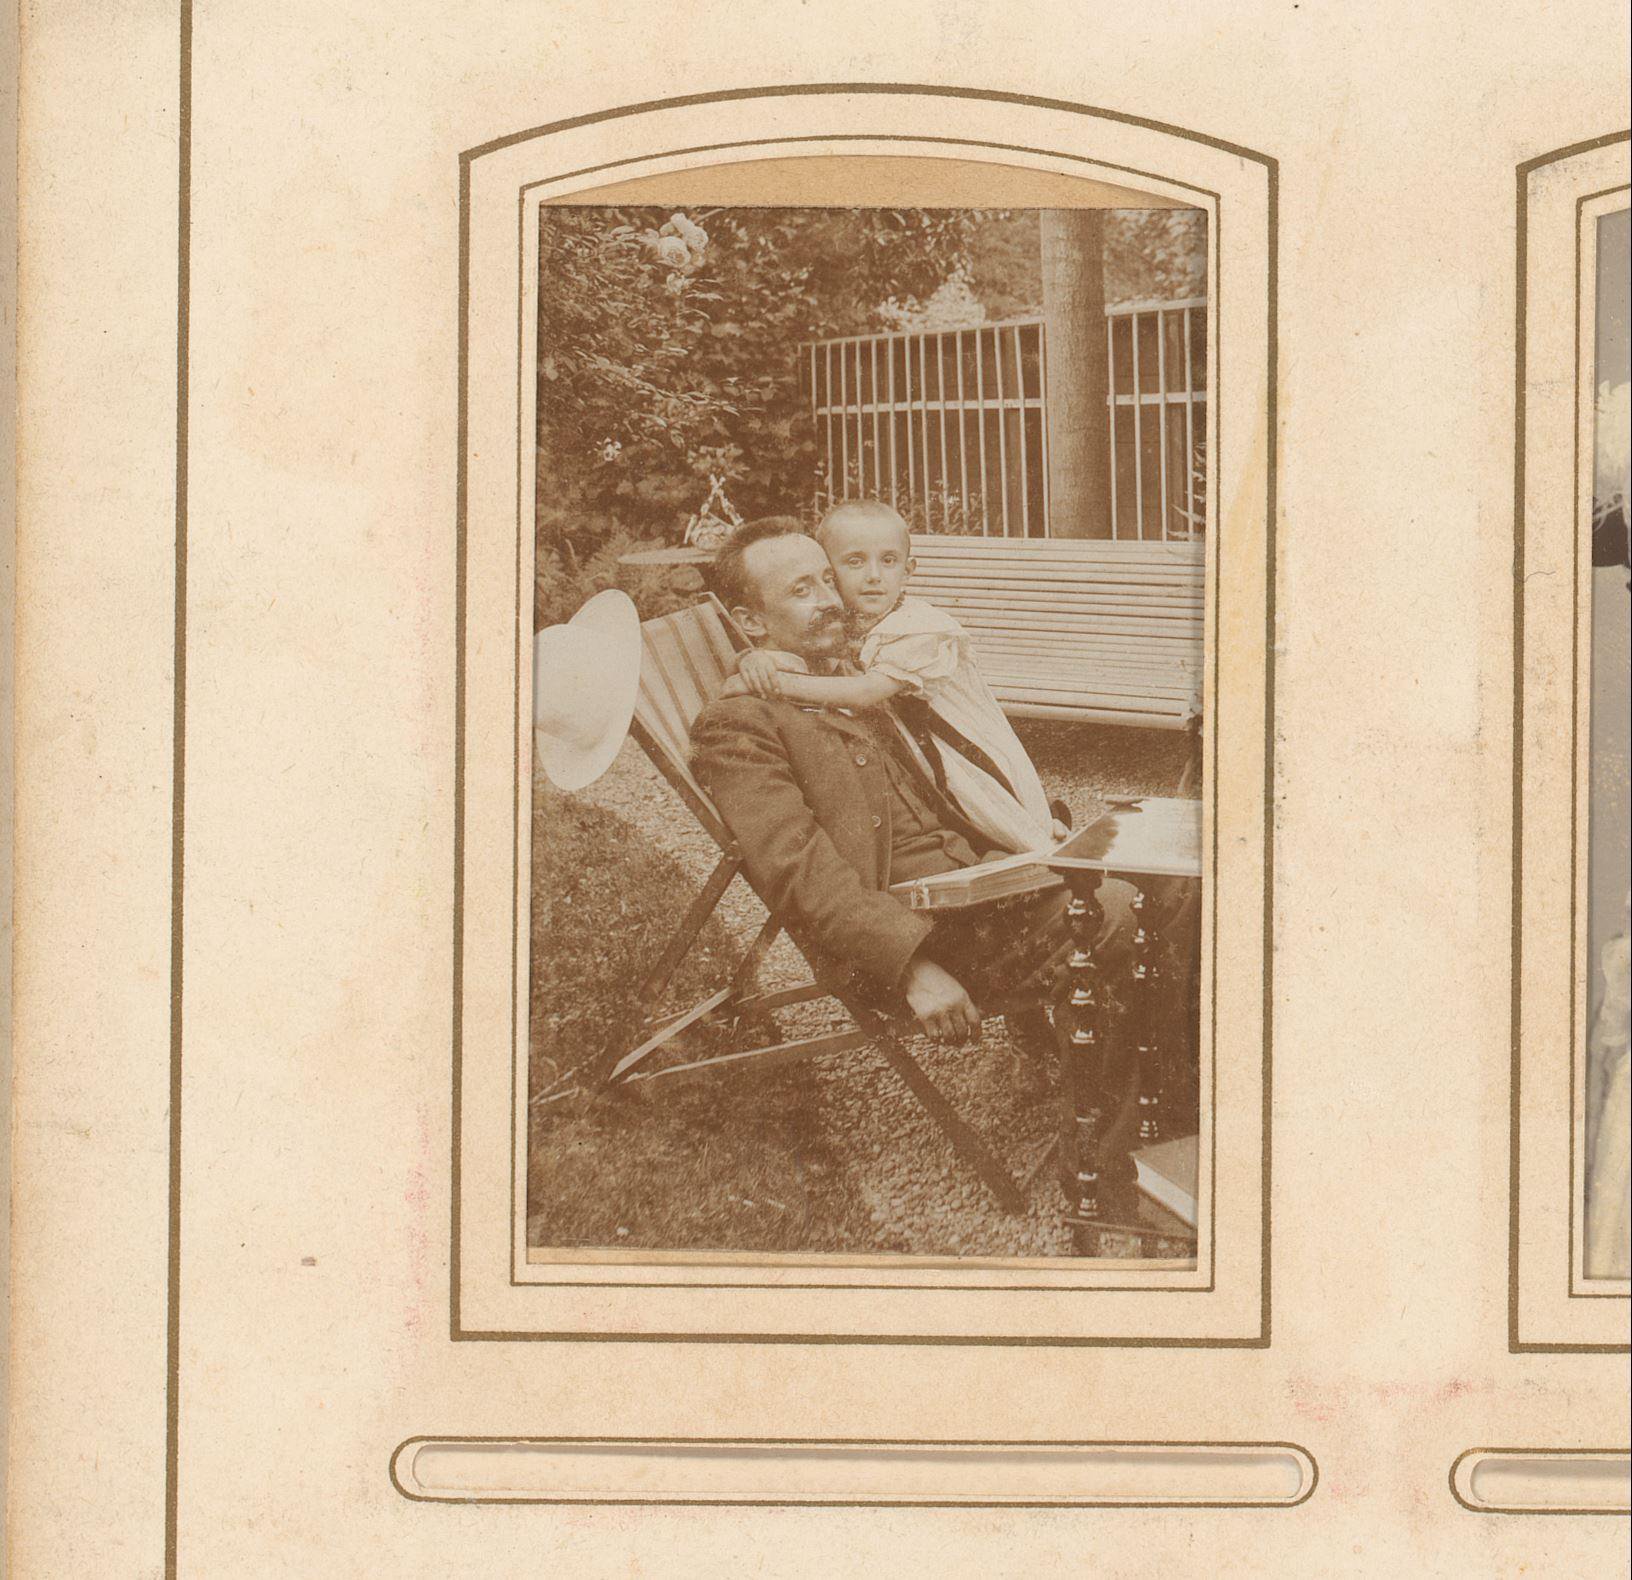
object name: album leaf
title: Portret van een vader en kind in een tuin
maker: Anonymous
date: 1880-1900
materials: cardboard, paper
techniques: albumen print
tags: historical persons, father with son(s) (father-love)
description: De afgebeelde tuin is ook afgebeeld op RP-F-F01008-34-2.